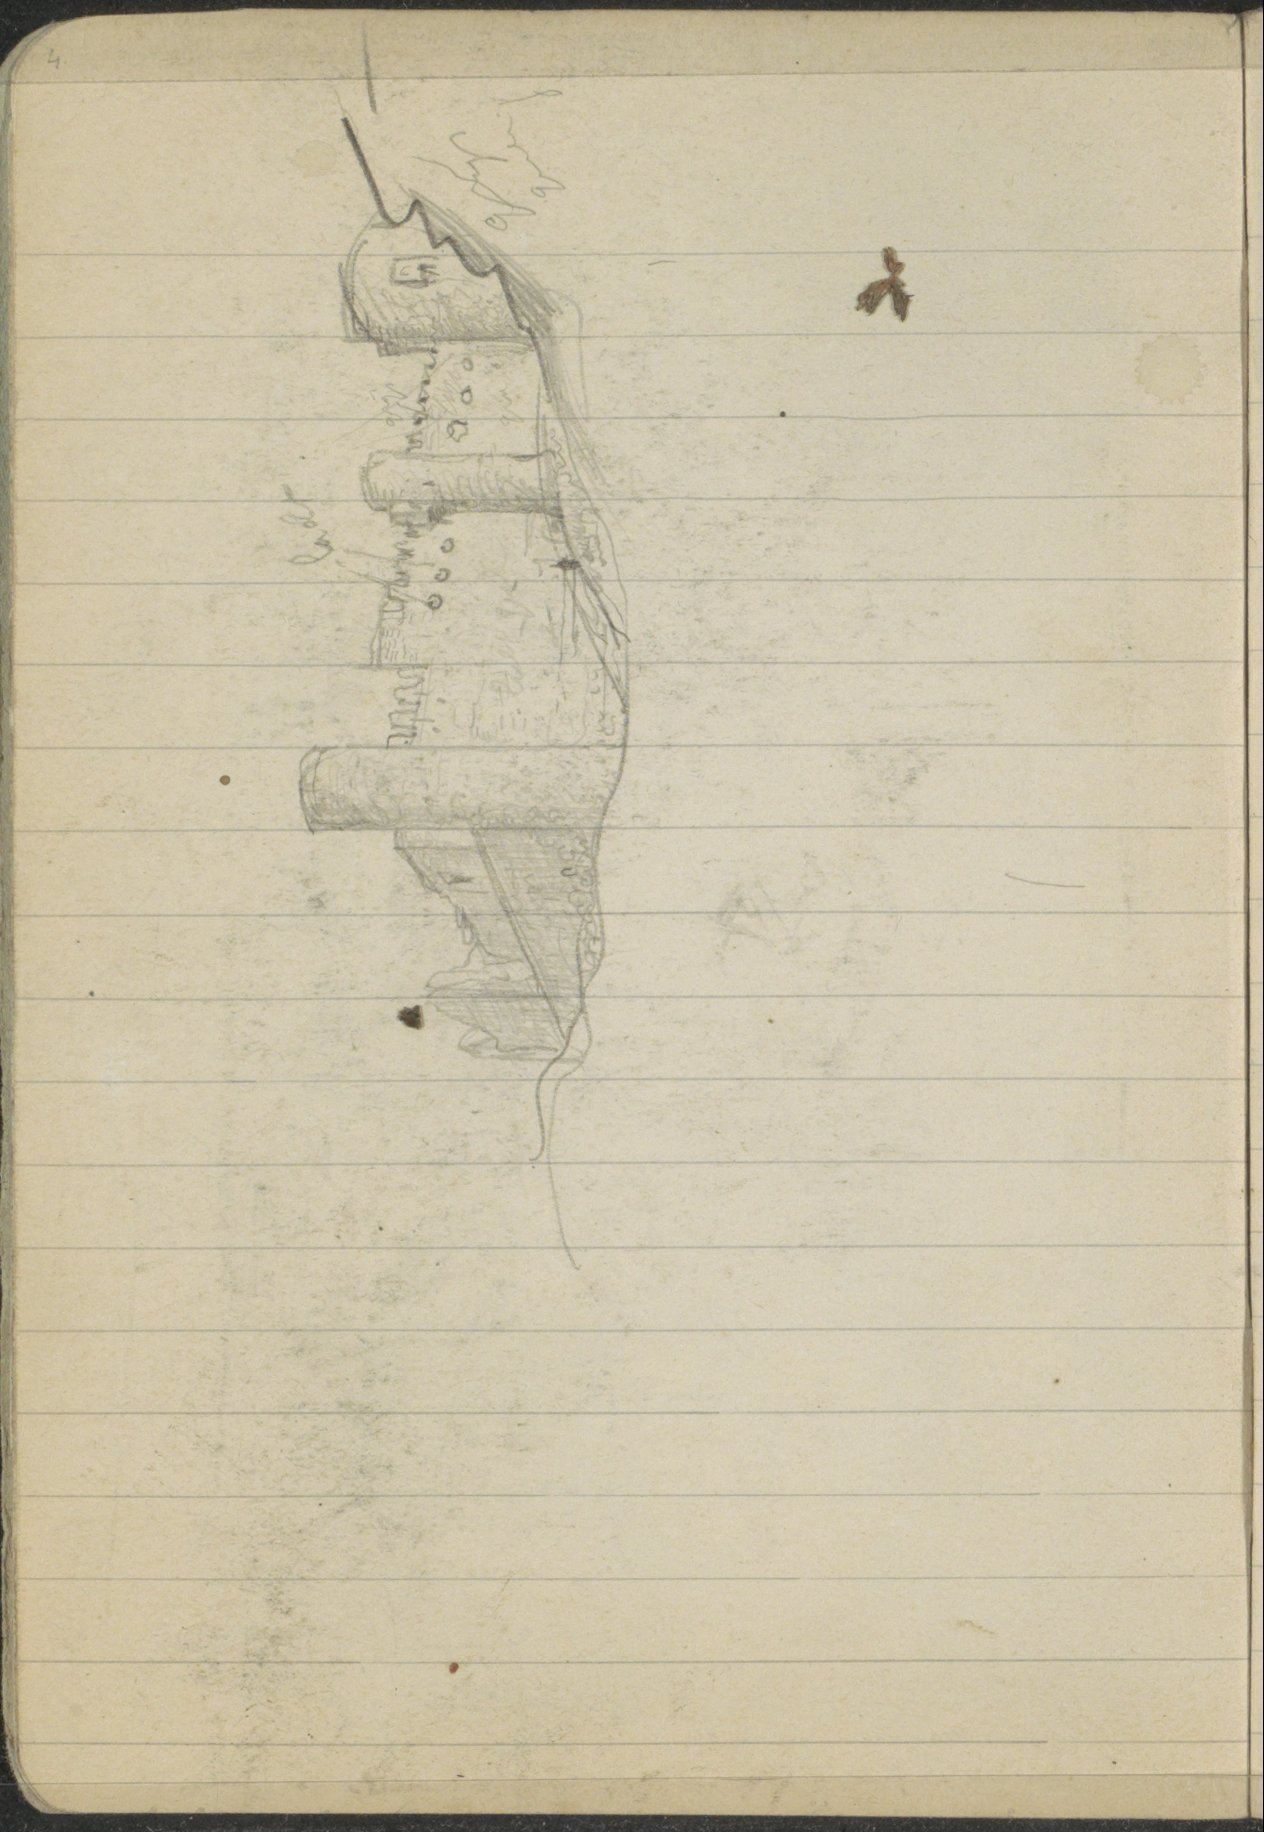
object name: sketchbook leaf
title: San Servando Kasteel in Toledo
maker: marius bauer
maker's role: draughtsman, print maker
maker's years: 1867-1932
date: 1902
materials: pencil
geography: toledo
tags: castle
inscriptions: kleurnotitie, handgeschreven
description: Pagina 4 uit een schetsboek met 50 bladen.